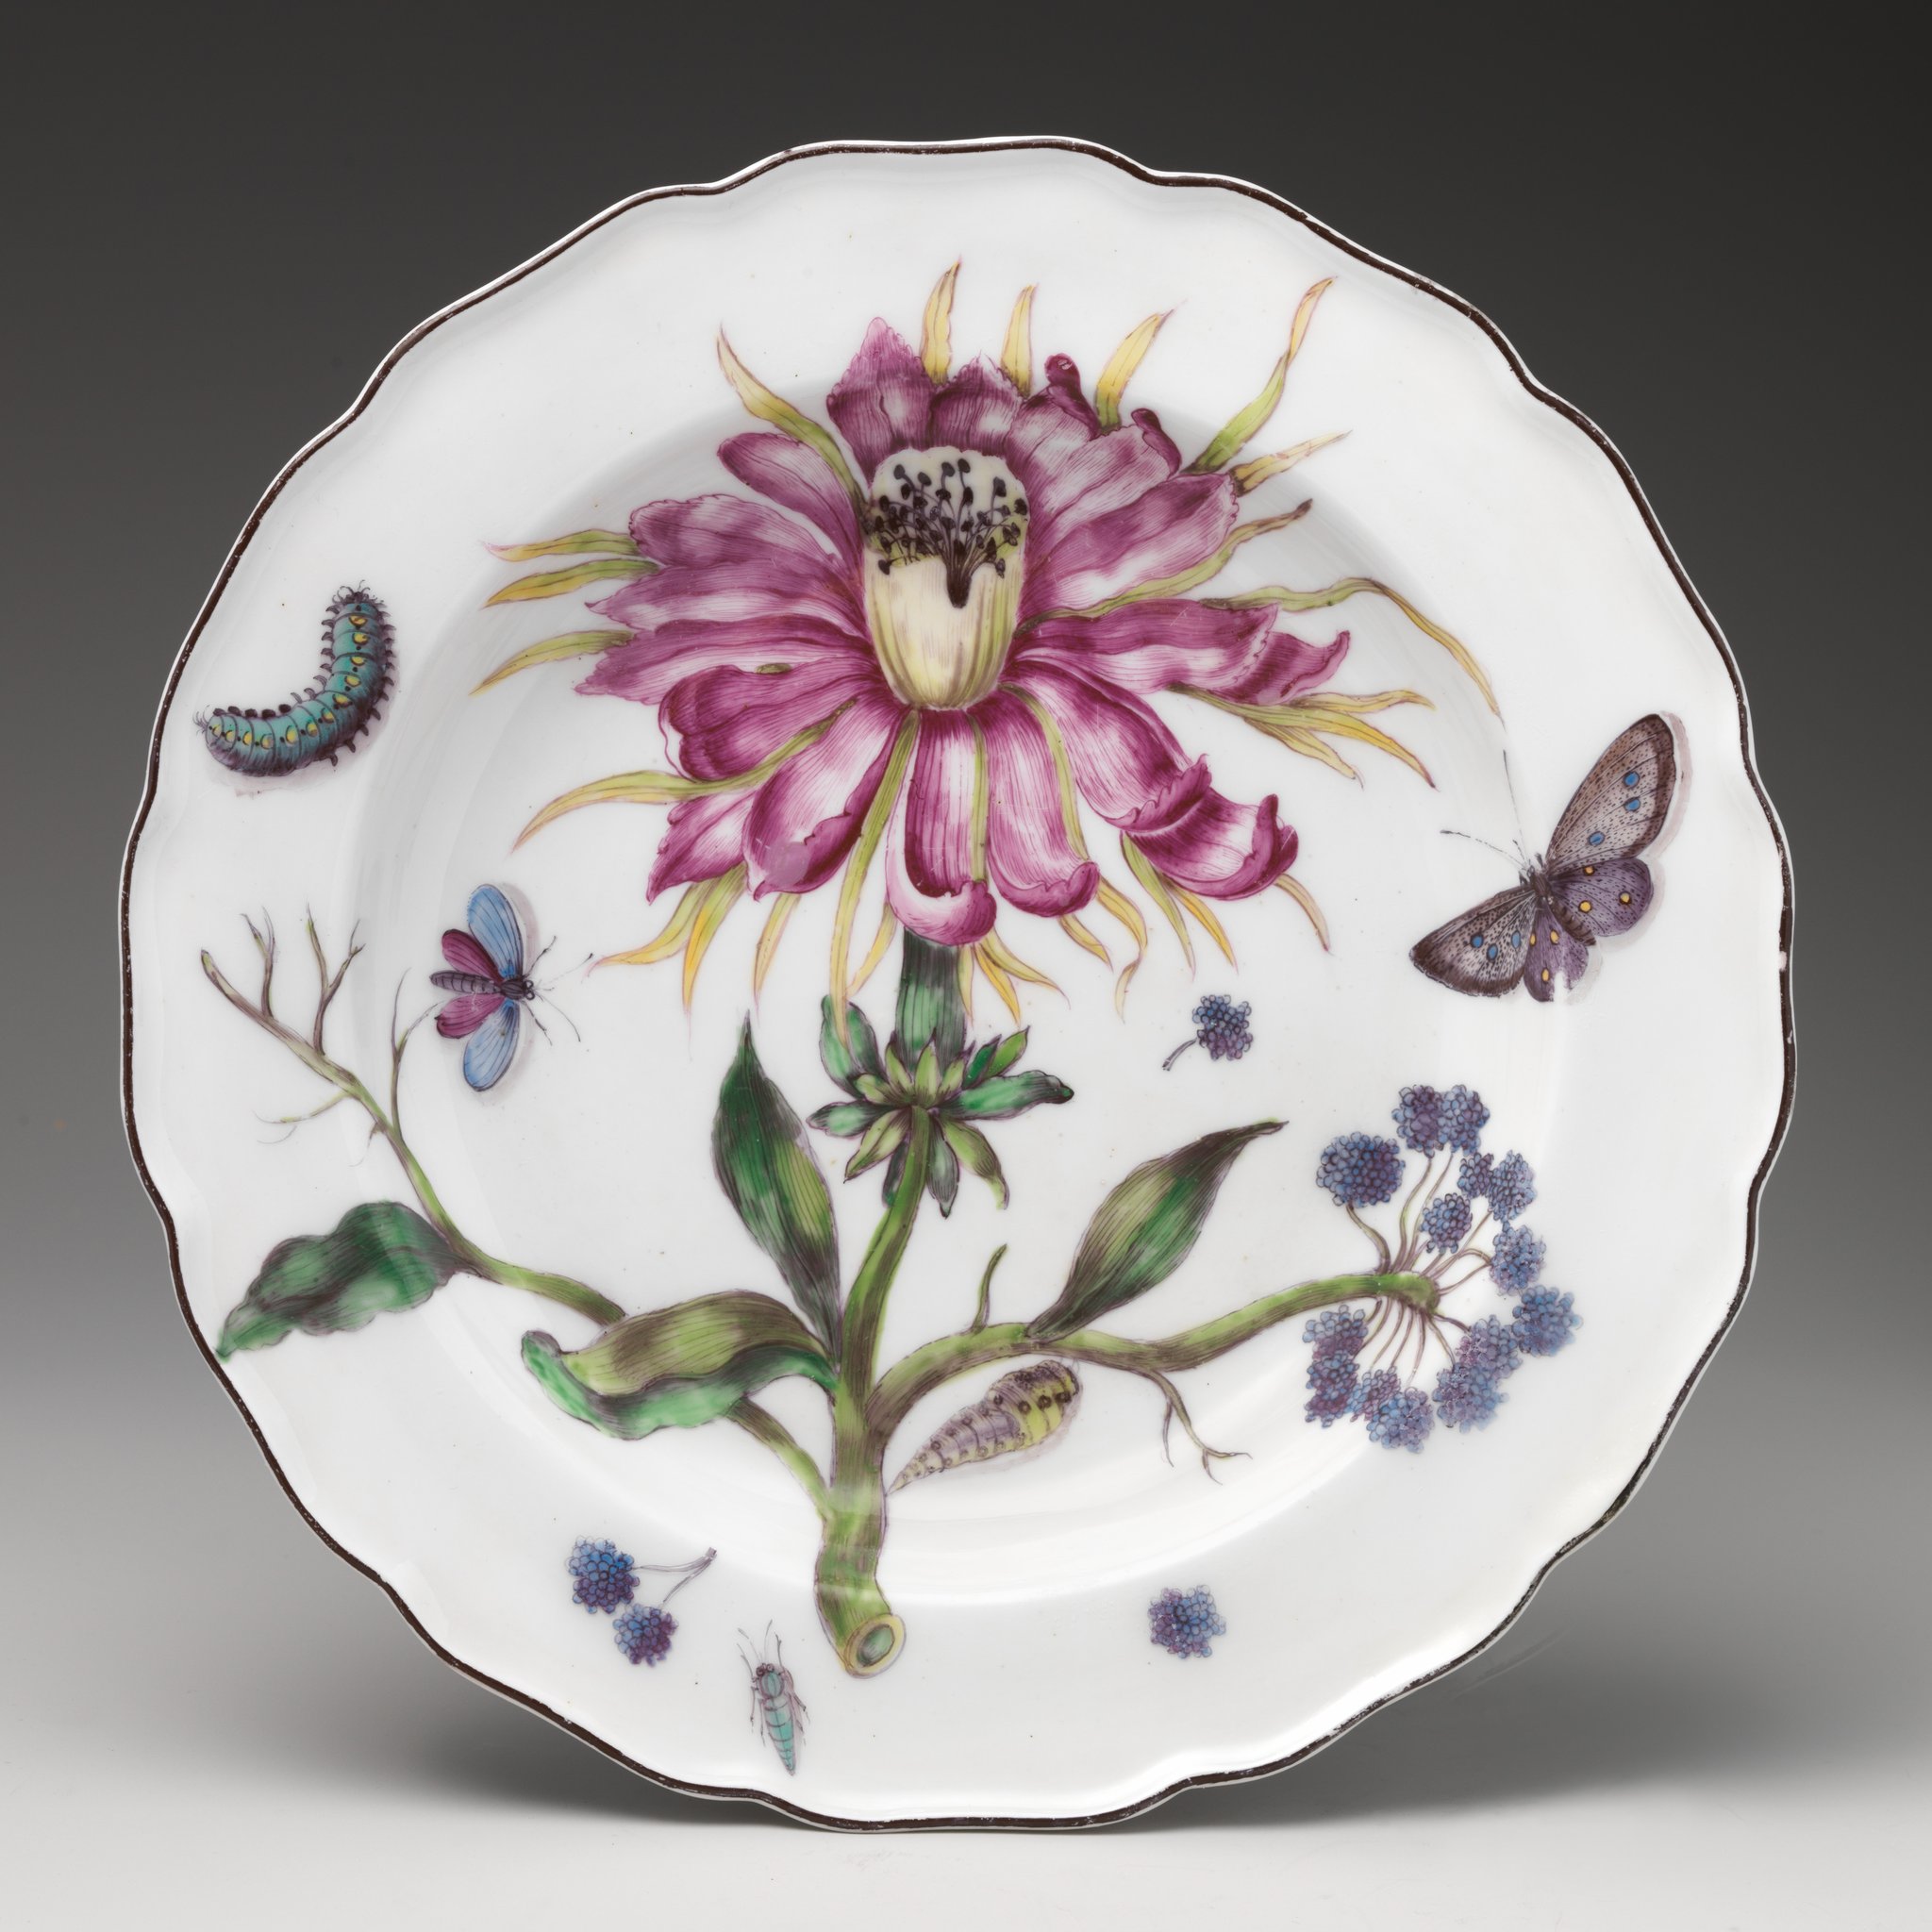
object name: plate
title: Botanical plate with thistle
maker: chelsea porcelain manufactory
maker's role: factory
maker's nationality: british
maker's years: 1744-1784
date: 1755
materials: enamel, soft paste porcelain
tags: insects,butterflies,flowers